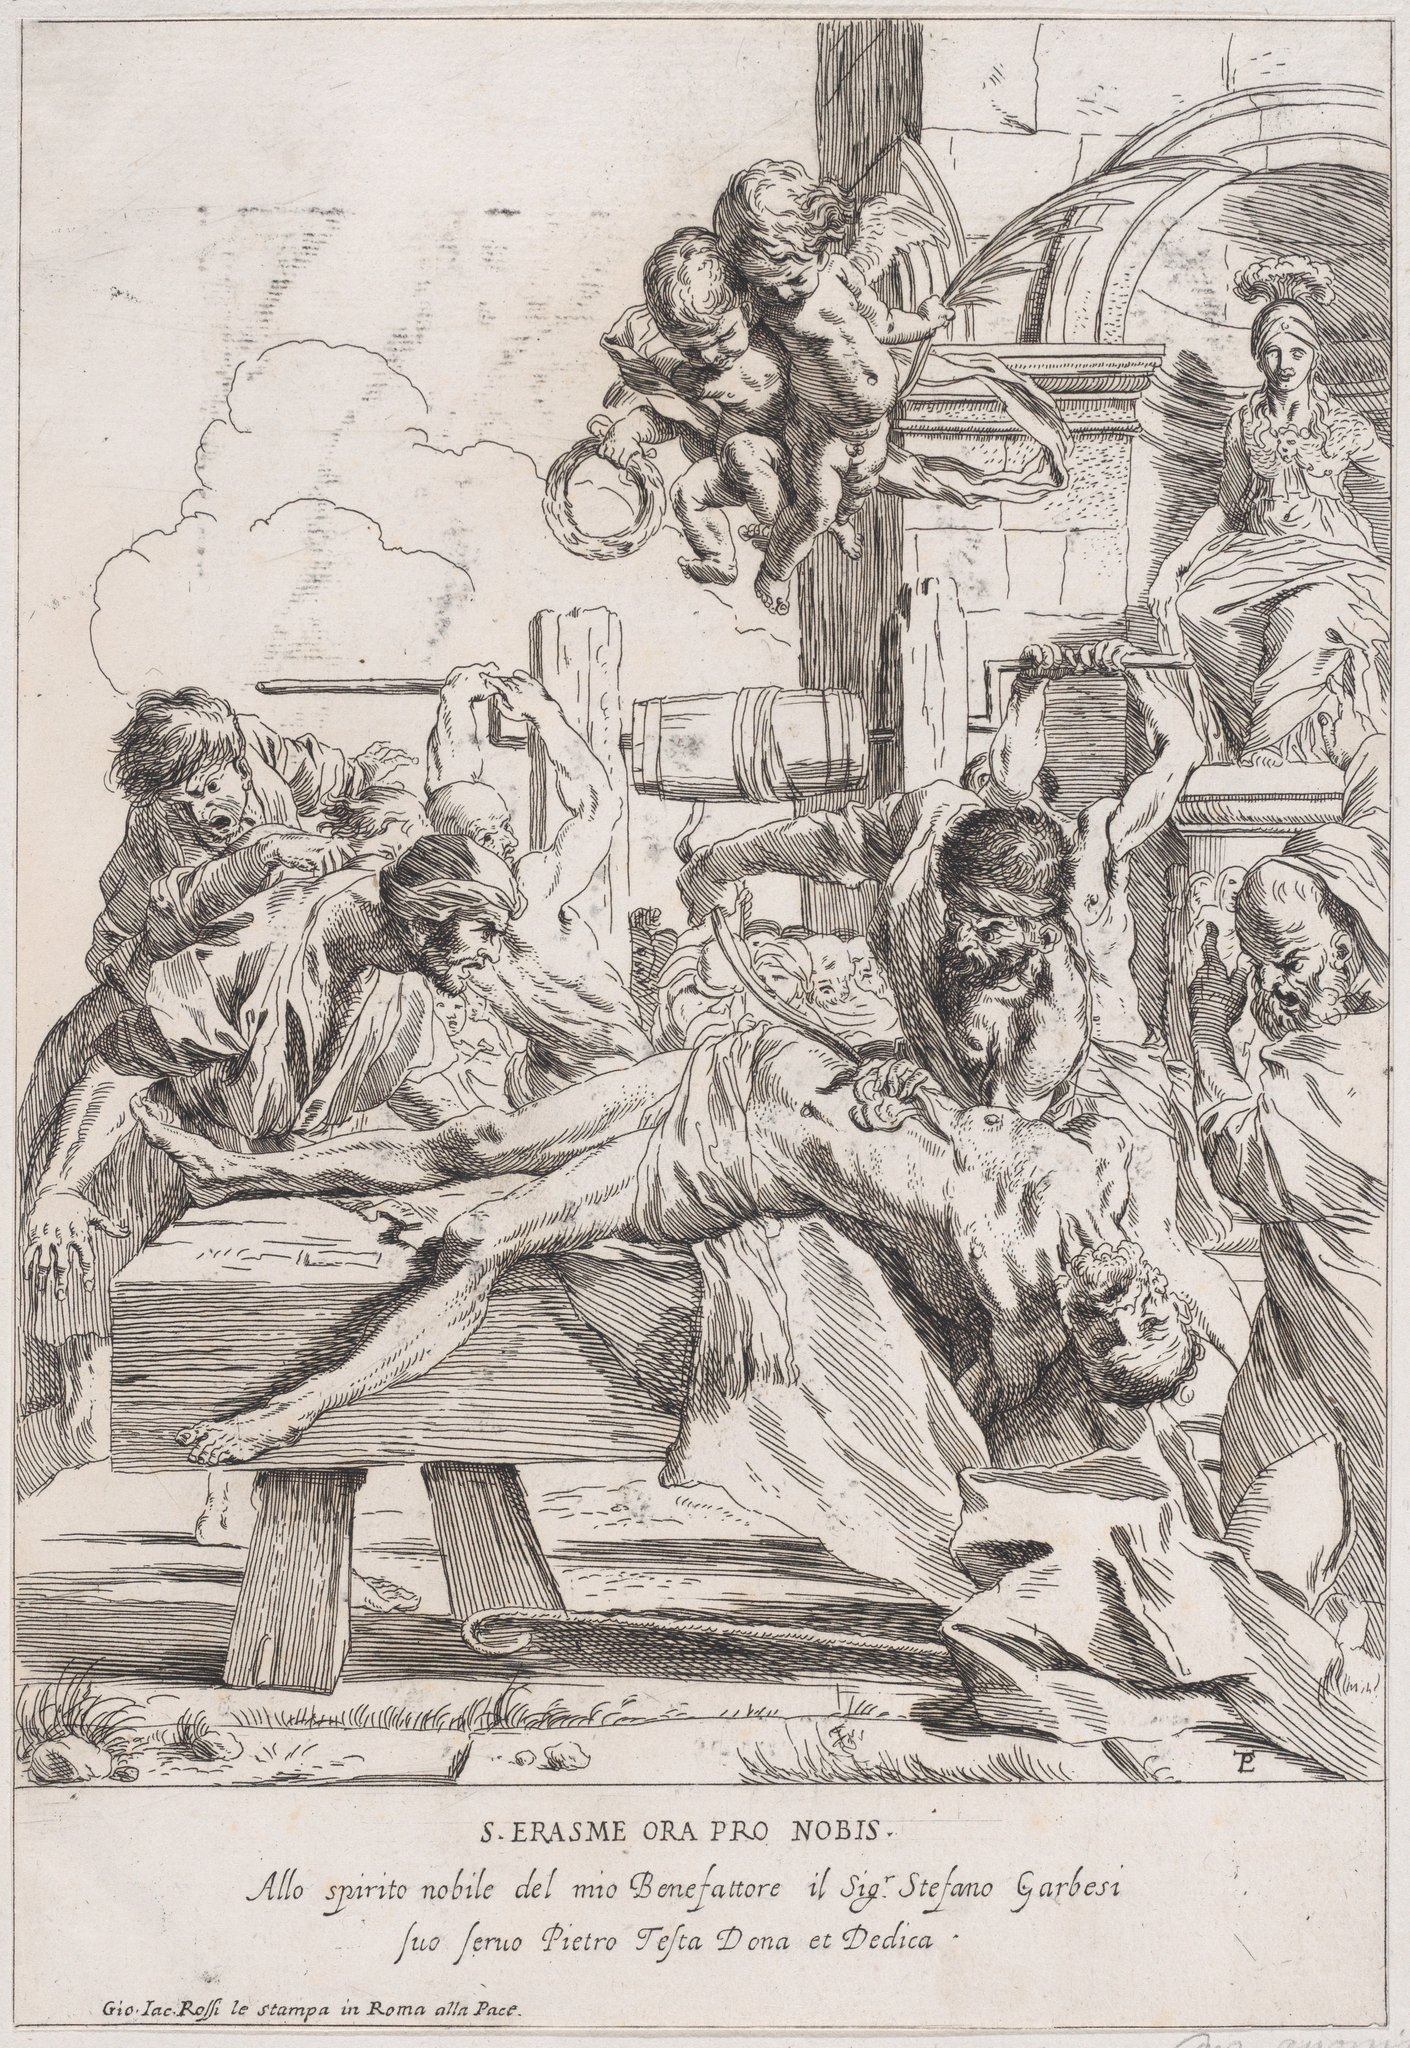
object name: print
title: The martyrdom of Saint Erasmus who is prostrate having his innards removed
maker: anonymous, 17th century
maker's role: artist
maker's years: 1600-1700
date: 1630-1660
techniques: etching